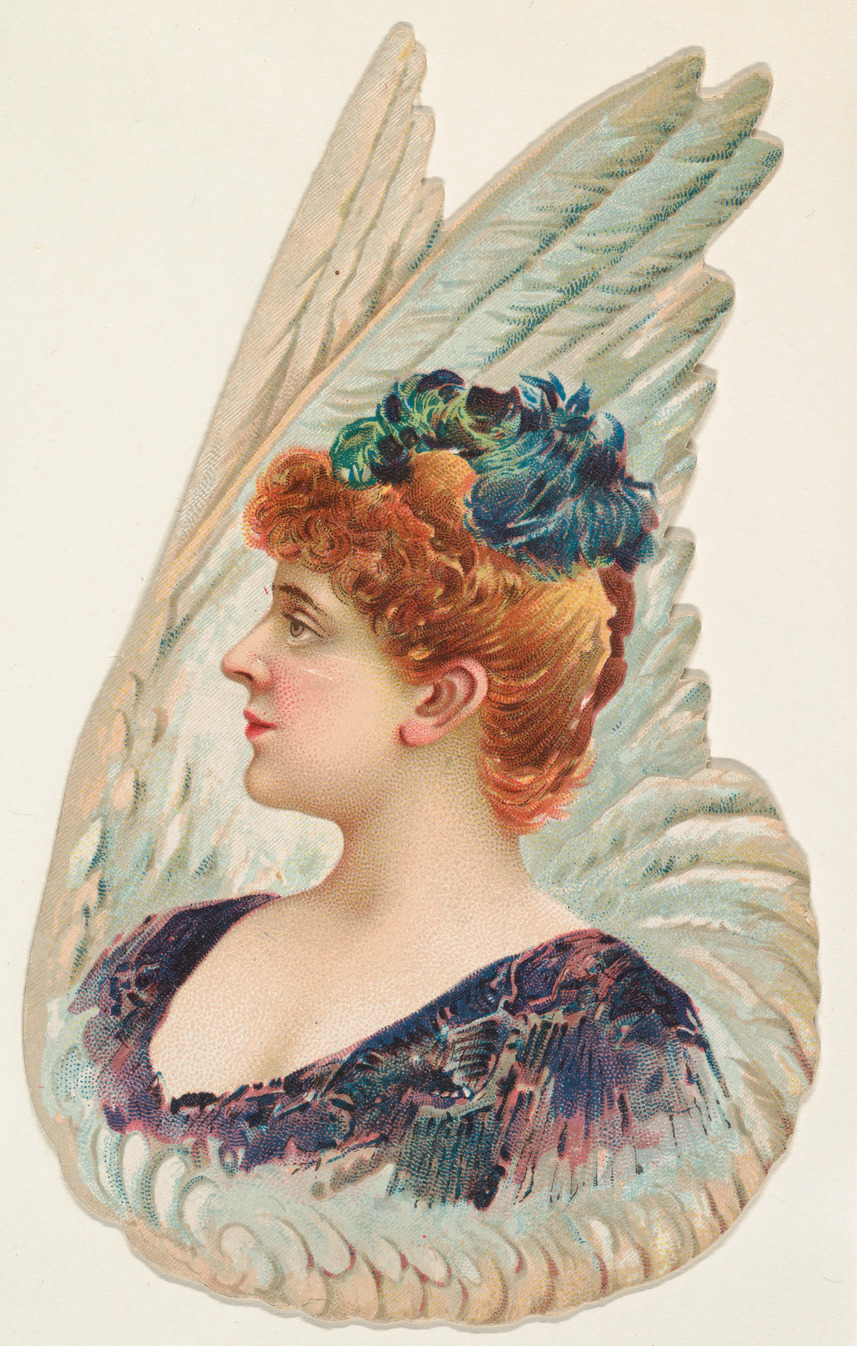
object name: print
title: Wings of a Bird, from the Novelties series (N122) issued by Gail & Ax Tobacco to promote Navy Long Cut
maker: gail & ax tobacco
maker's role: publisher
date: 1889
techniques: color lithograph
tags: profiles,women